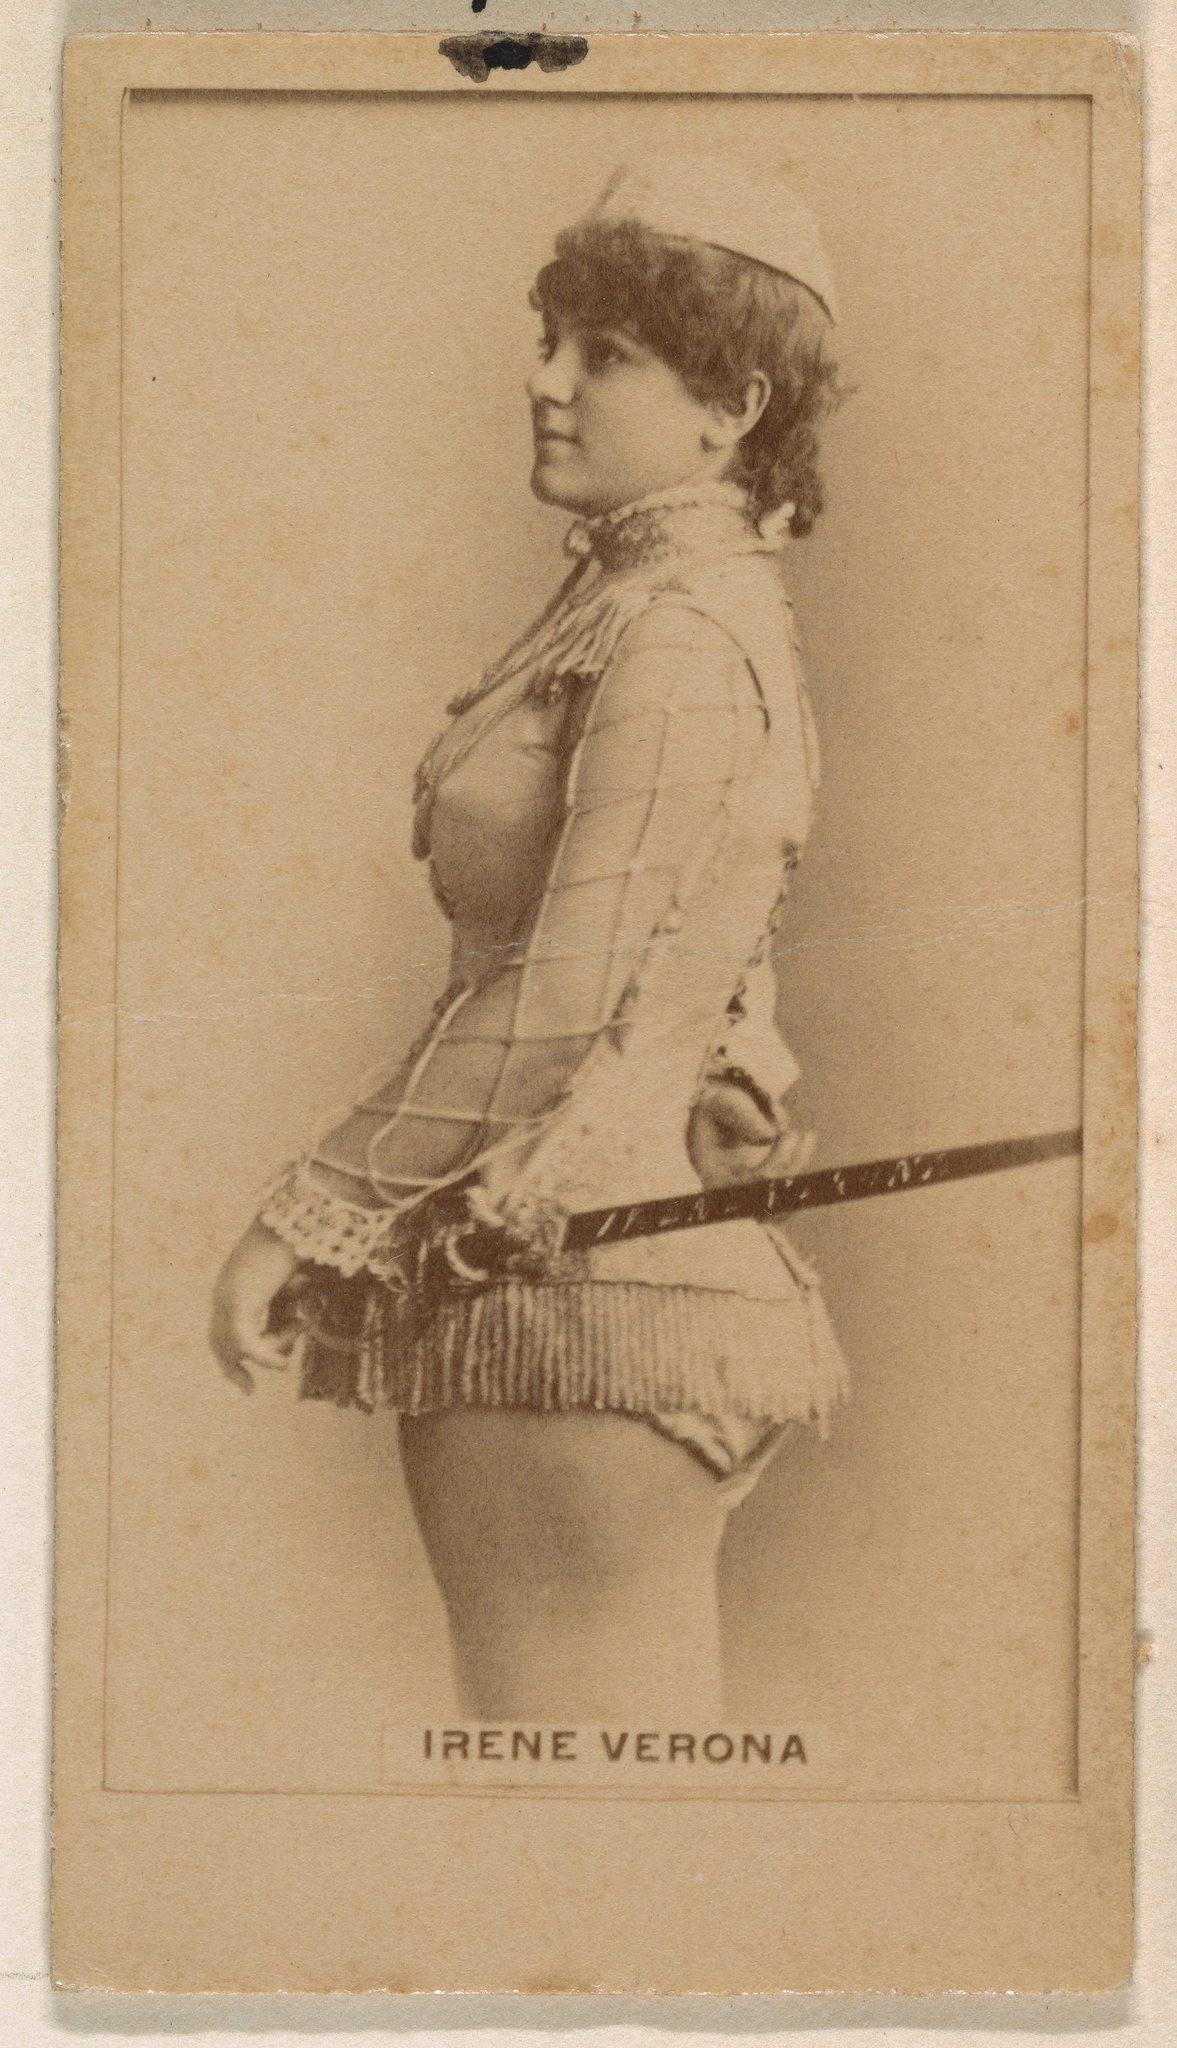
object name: photograph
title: Irene Verona, from the Actresses series (N245) issued by Kinney Brothers to promote Sweet Caporal Cigarettes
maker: kinney brothers tobacco company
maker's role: publisher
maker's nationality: american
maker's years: 1869-2011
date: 1890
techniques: albumen silver print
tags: portraits,women,actresses